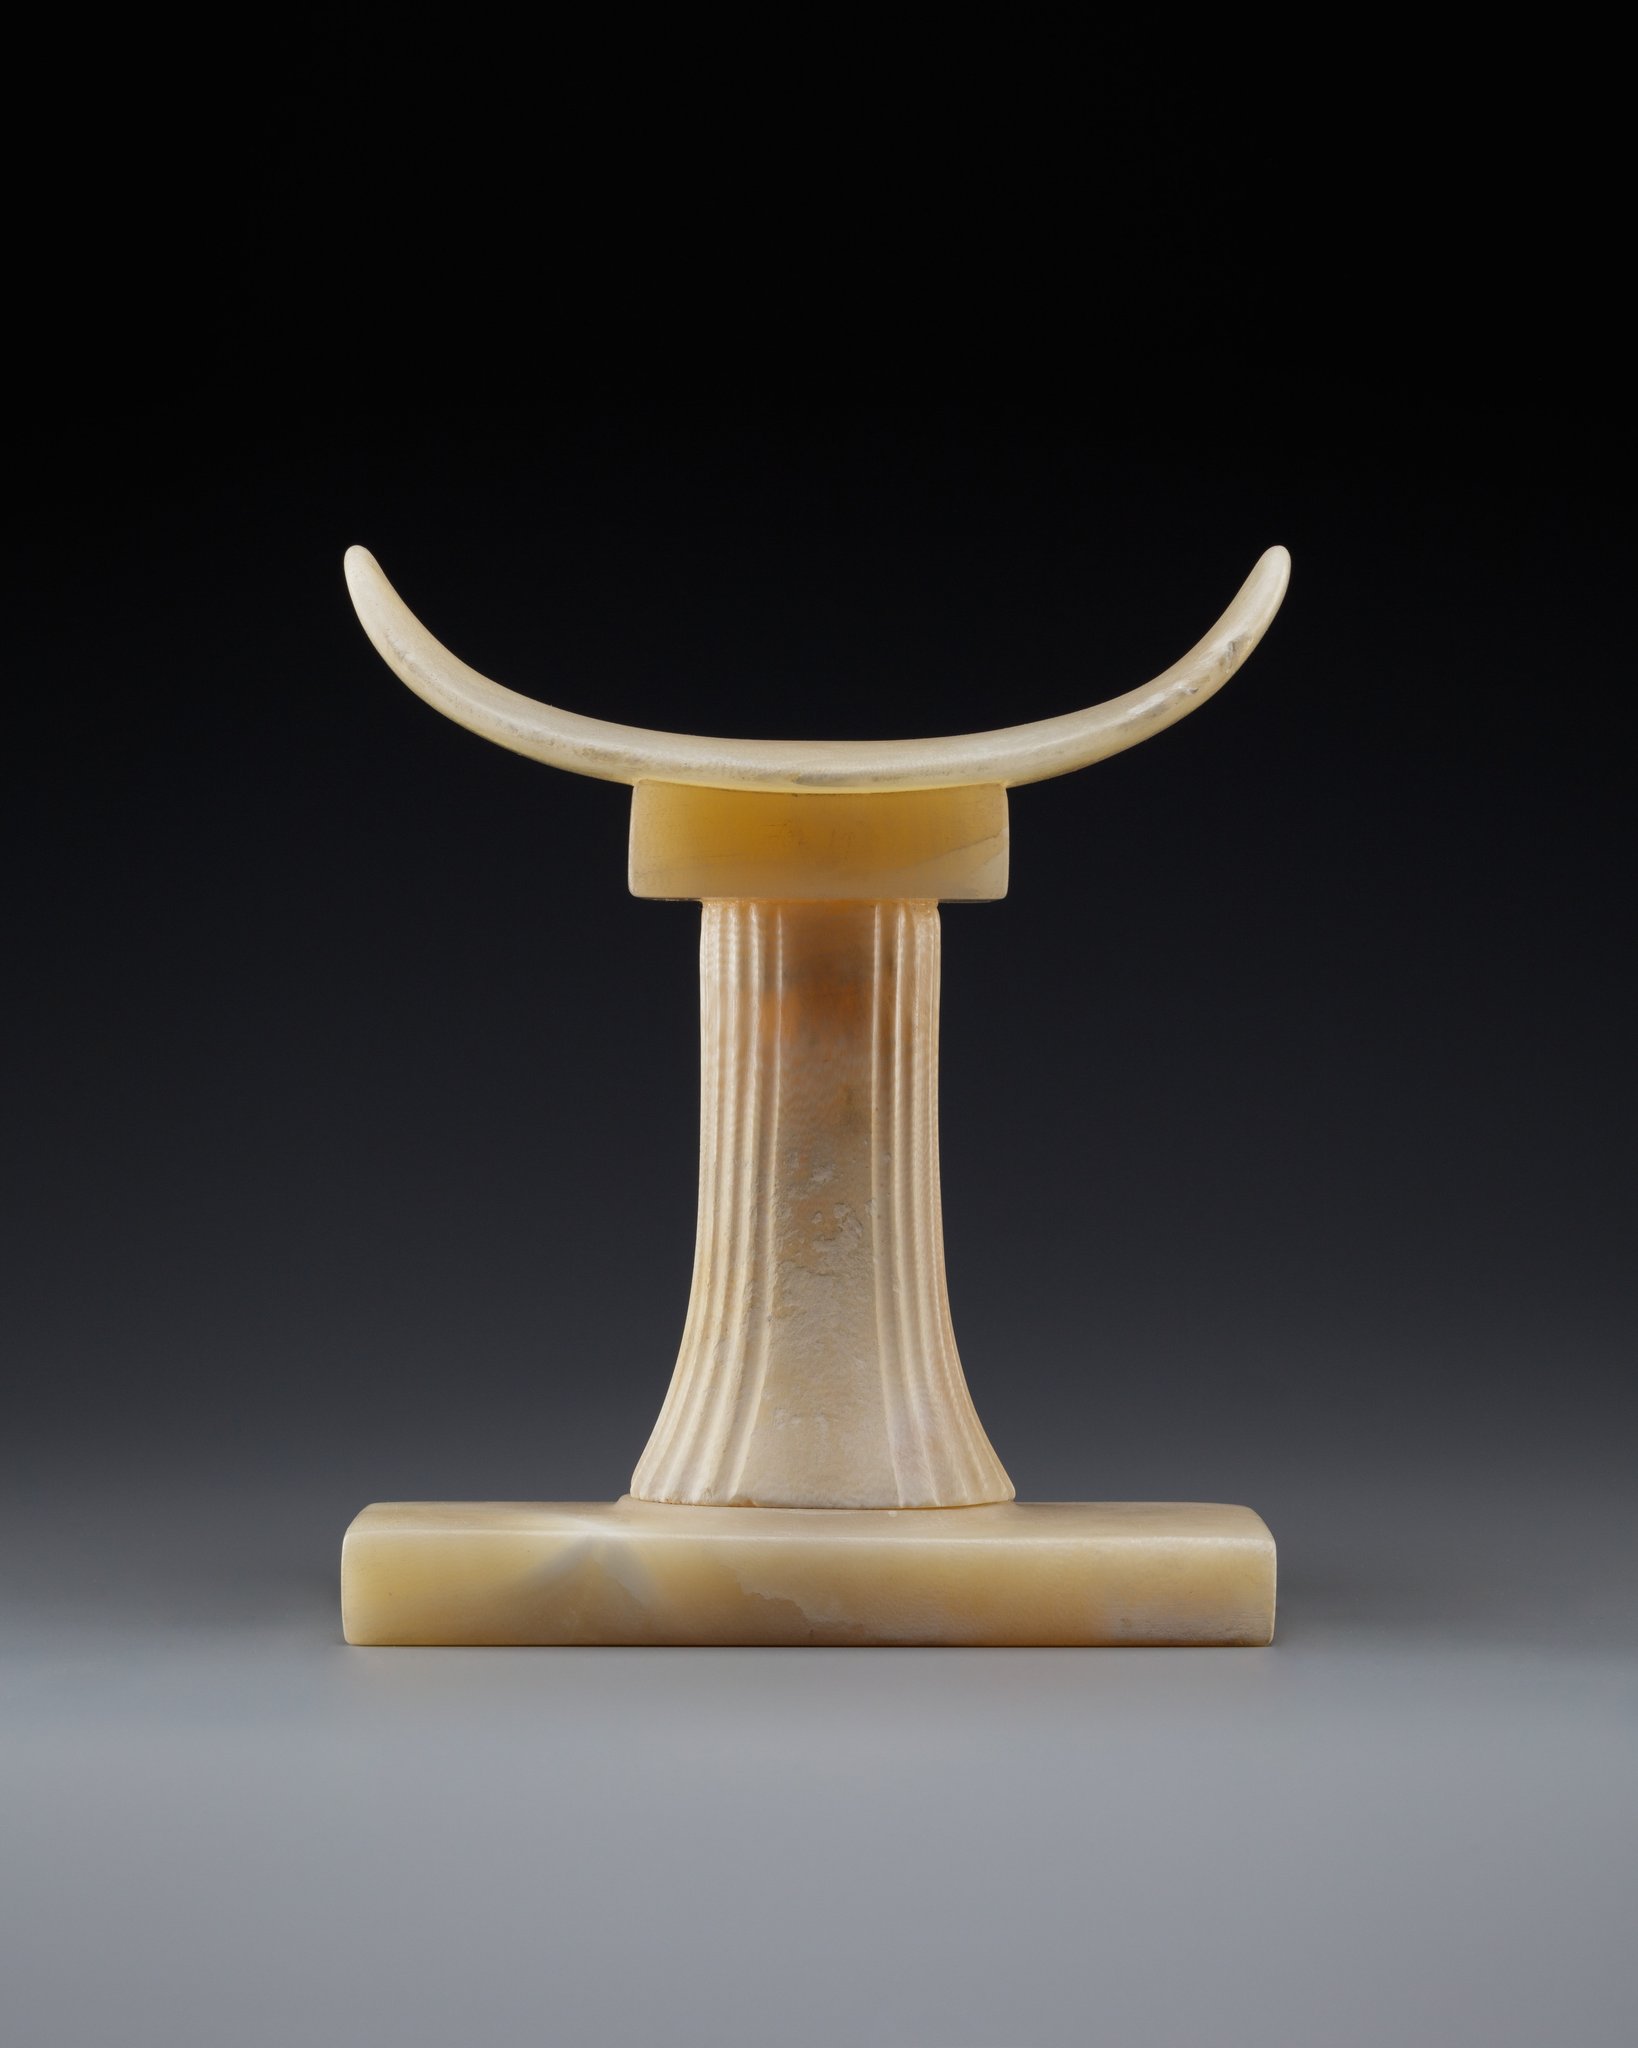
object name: headrest, khentika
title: Headrest of Khentika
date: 2323-2150 BCE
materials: stone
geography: egypt